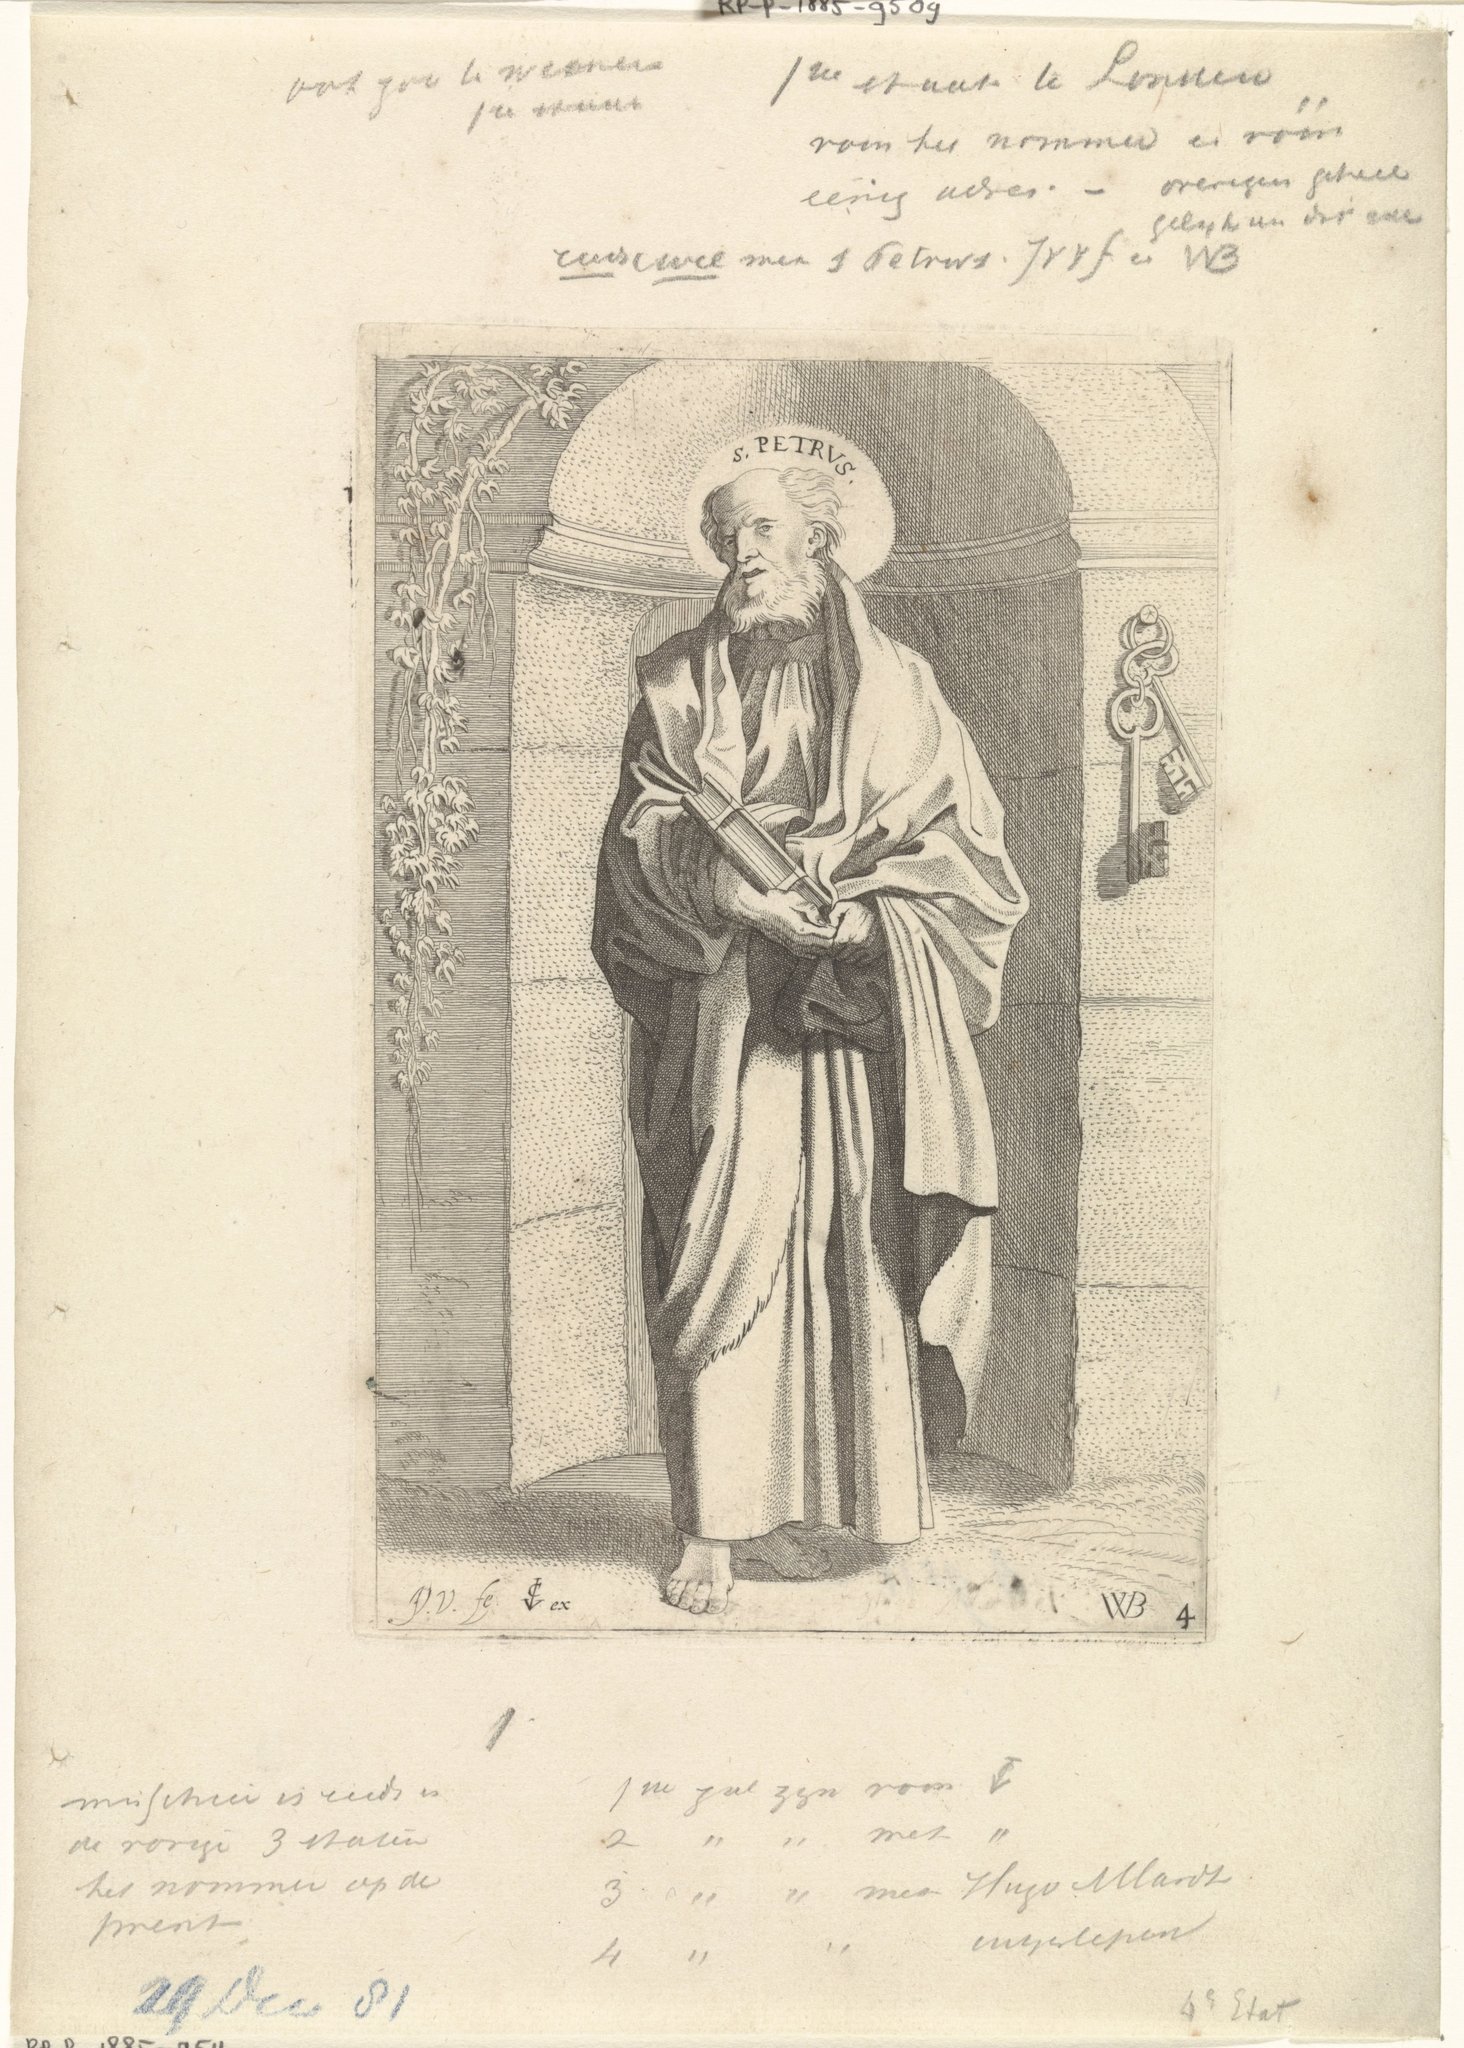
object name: print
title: H. Petrus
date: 1603-1652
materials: paper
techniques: engraving, etching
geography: amsterdam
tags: the apostle peter, first bishop of rome; possible attributes: book, cock, (upturned) cross, (triple) crozier, fish, key, scroll, ship, tiara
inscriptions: signature: ‘JV.V. fe.’, signature: ‘WB’, collector's mark: Lugt 2228, collector's mark, number: ‘4’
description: De apostel Petrus, staand voor een nis. Hij heeft een boek in de hand. Aan de muur achter hem hangen twee sleutels.